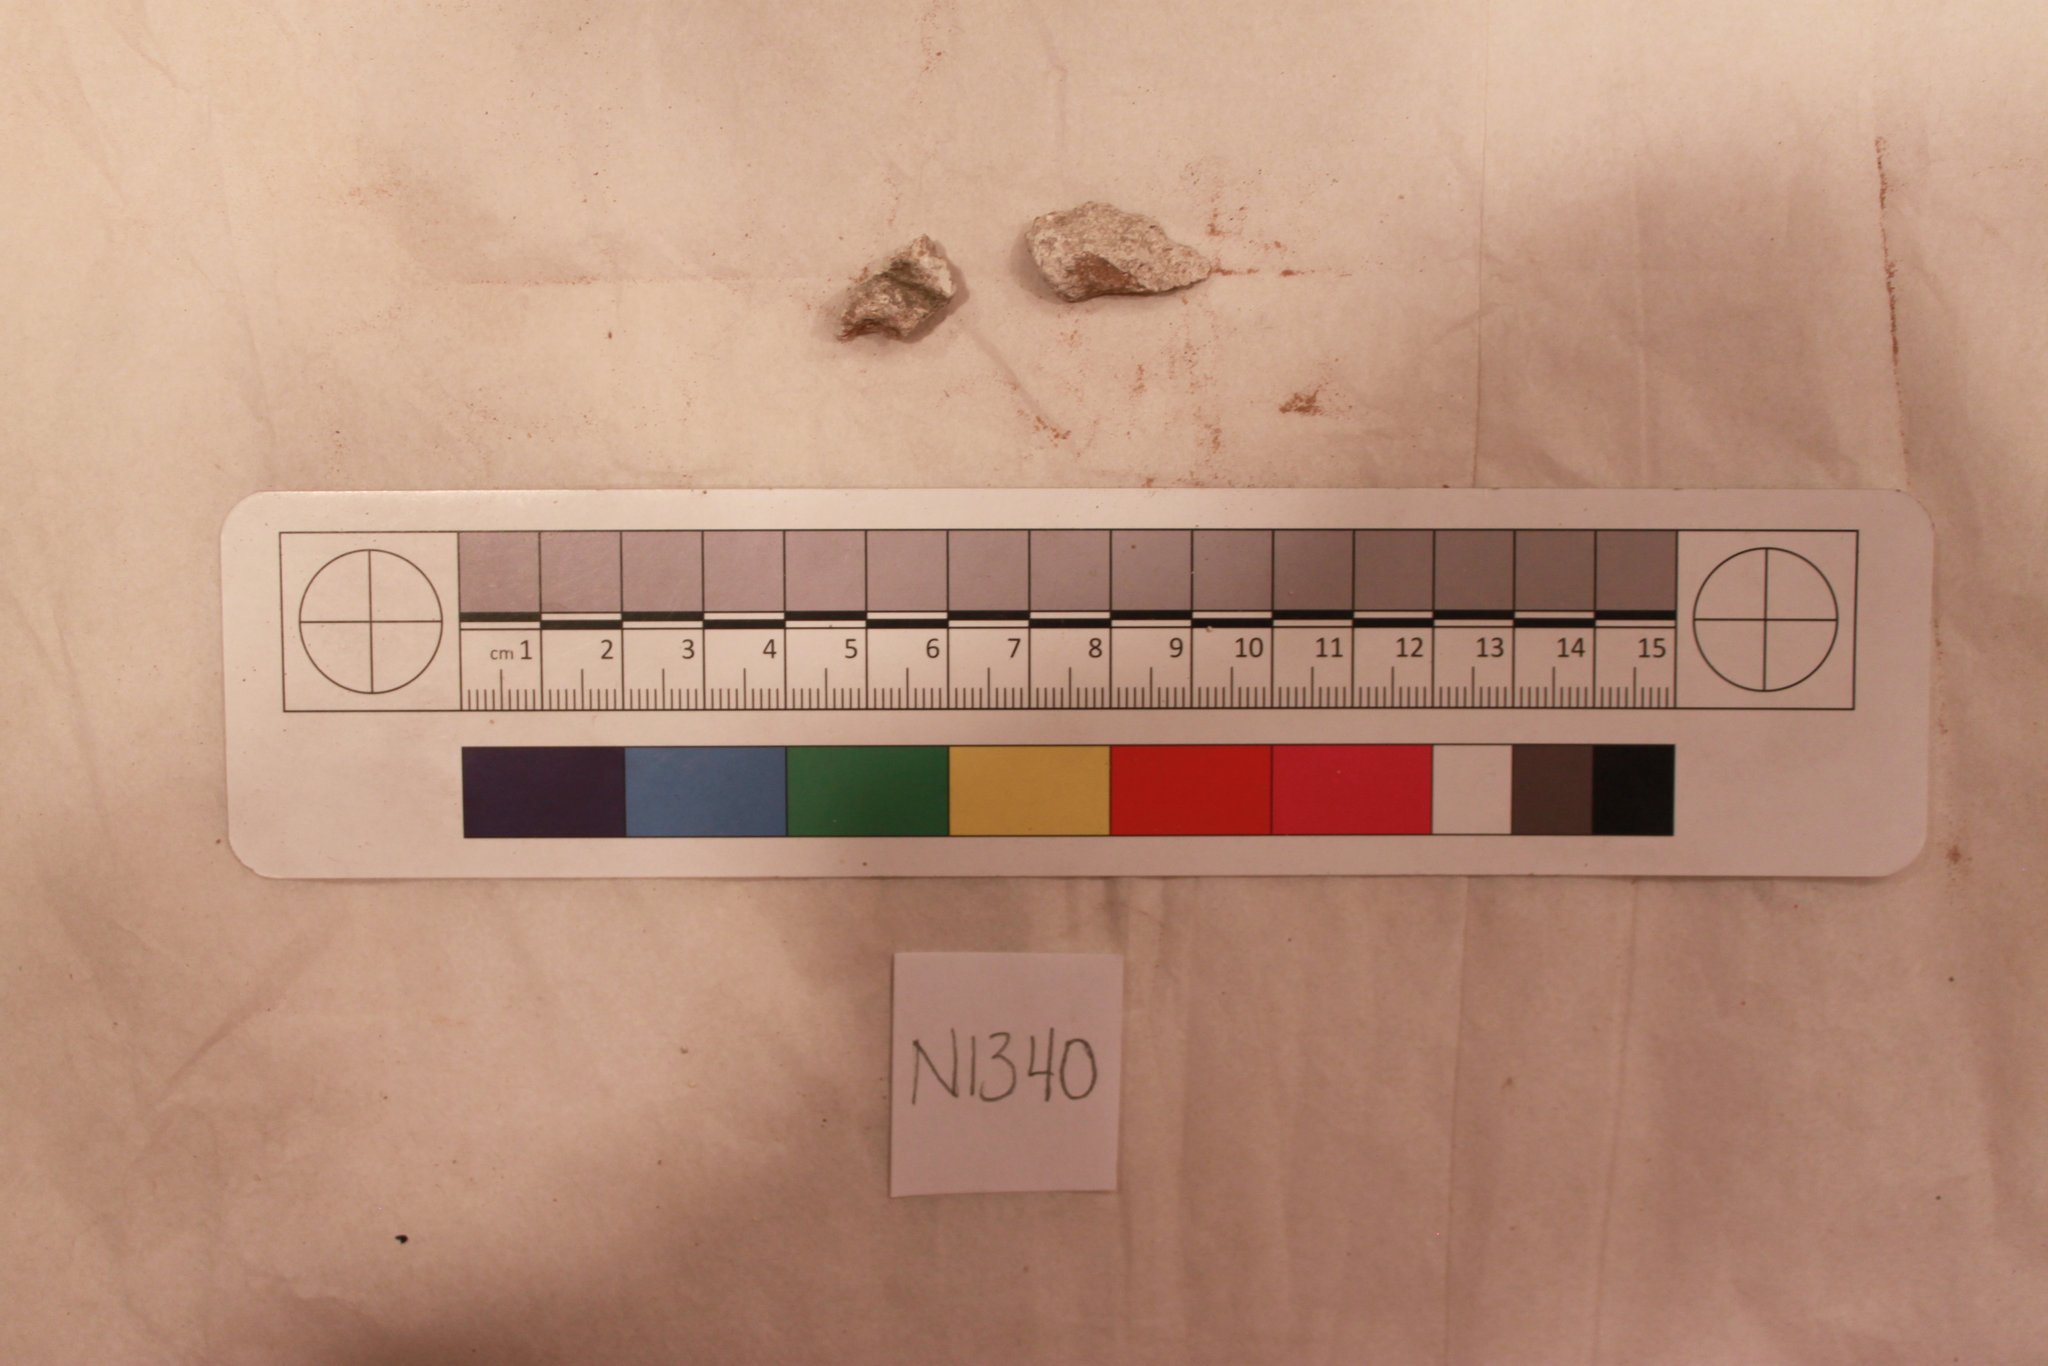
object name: fragment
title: Stucco Fragment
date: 701-1200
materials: plaster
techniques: carving, painting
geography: iran